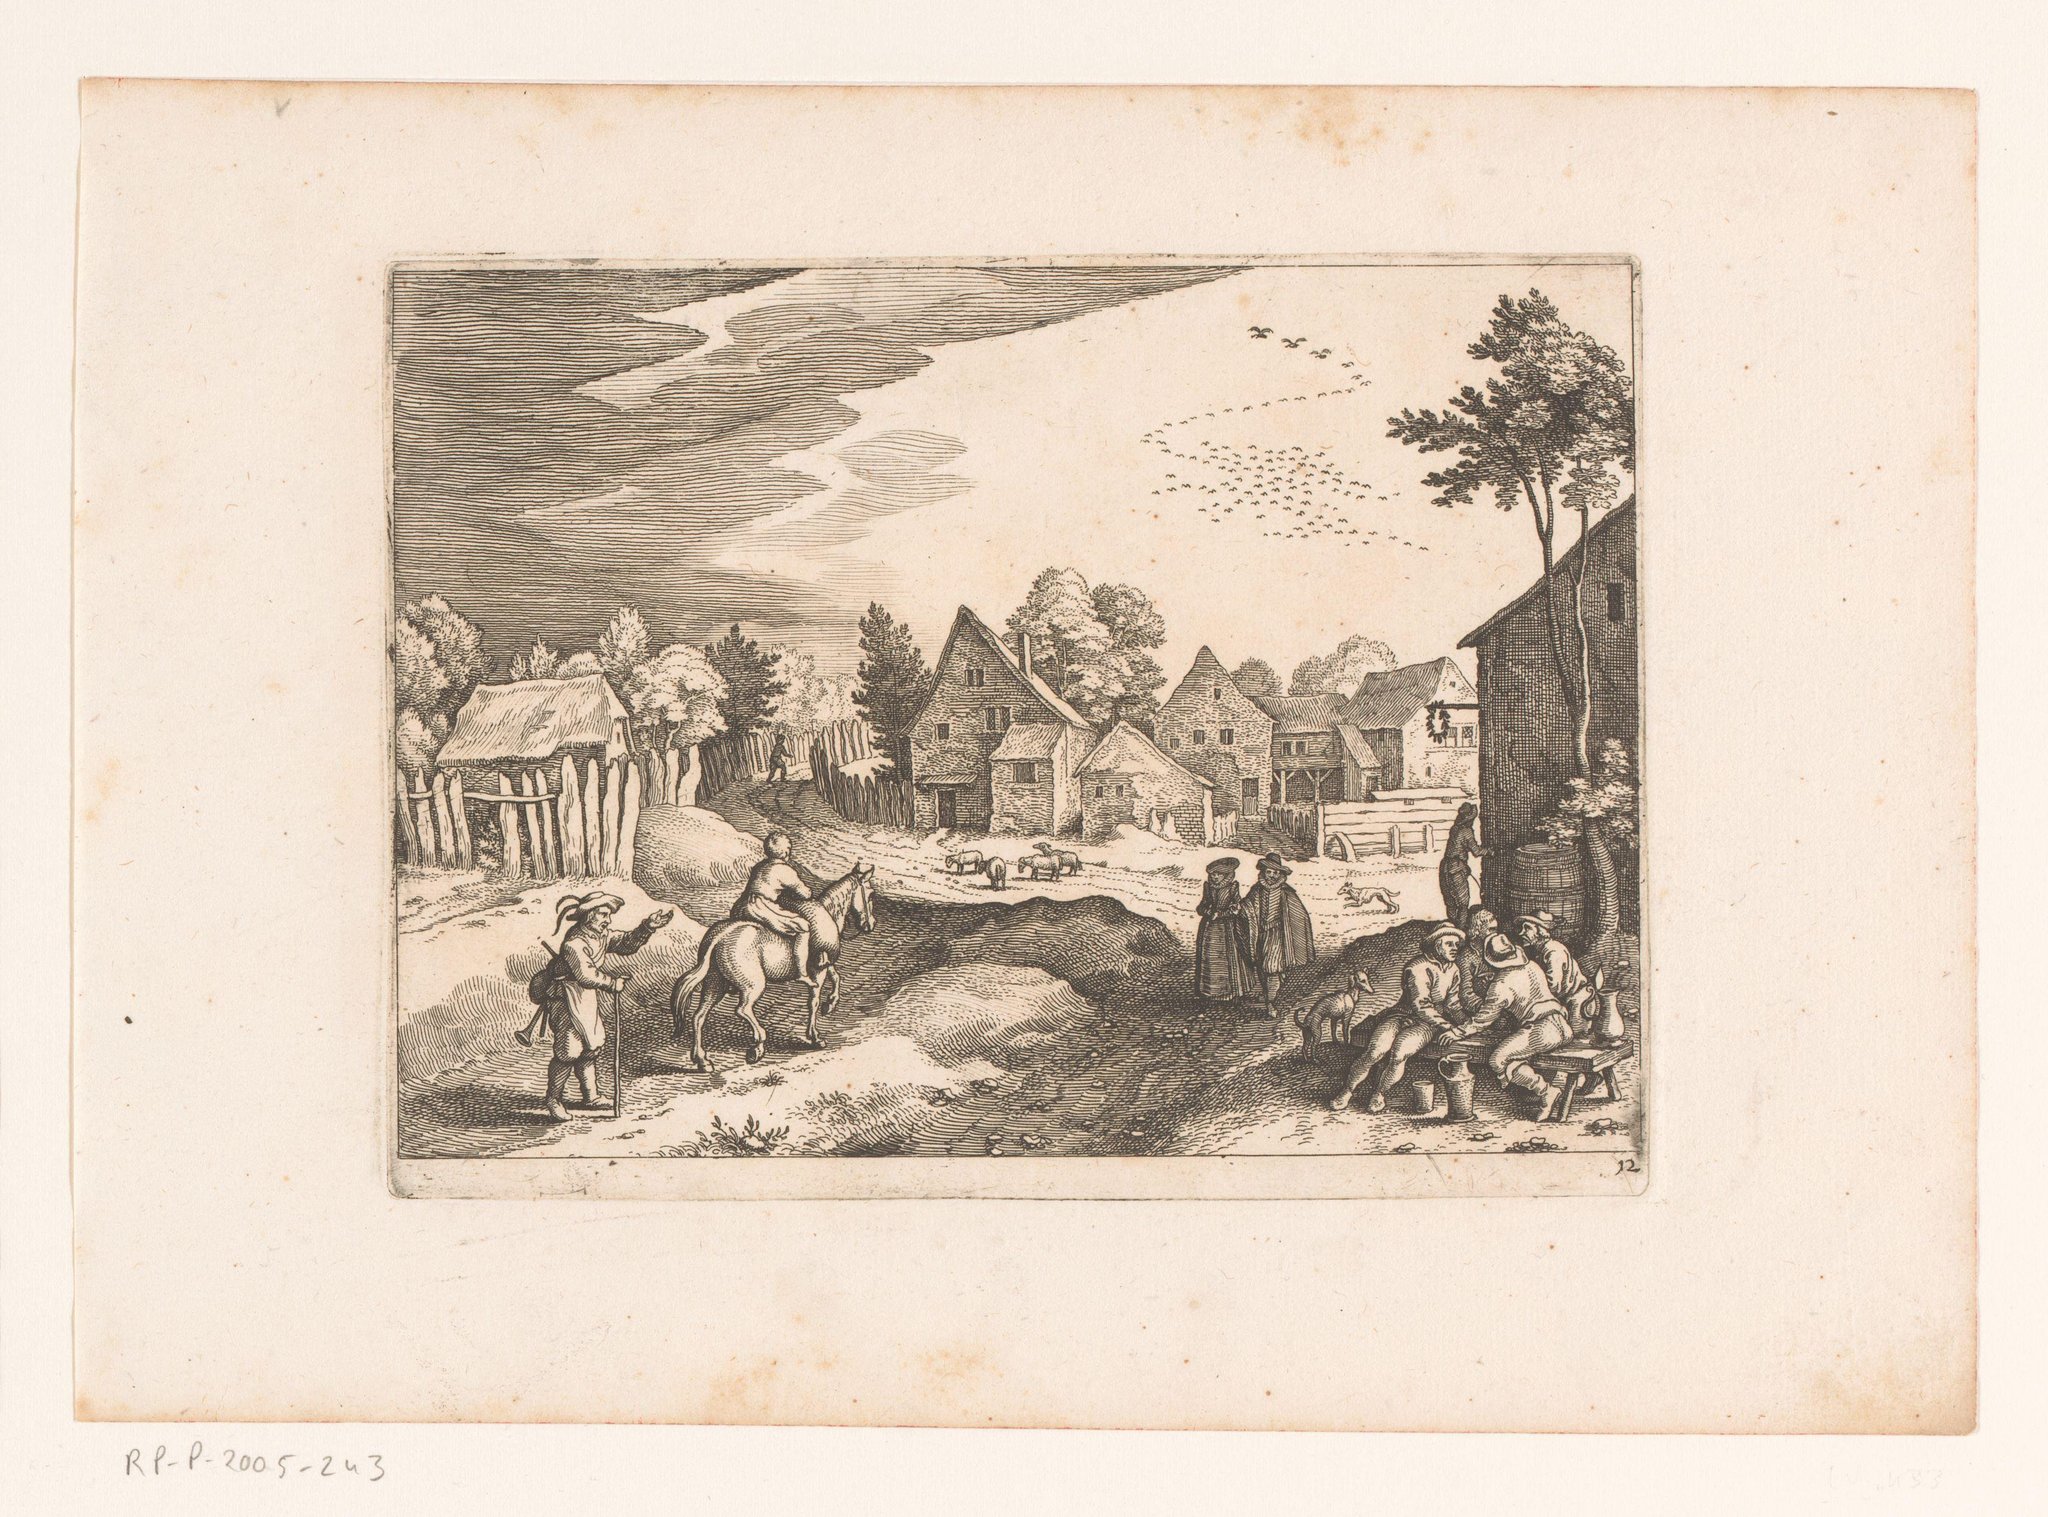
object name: print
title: Schwalbacher Reise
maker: matthäus merian (i)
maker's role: print maker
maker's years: 1593-1650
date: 1620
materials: paper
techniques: etching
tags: riding a horse, ass, or mule; rider, horseman, farmers, village, saluting, conversation, dialogue; conversation piece, couple of lovers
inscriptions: collector's mark: Lugt 2760, collector's mark: Lugt 2228